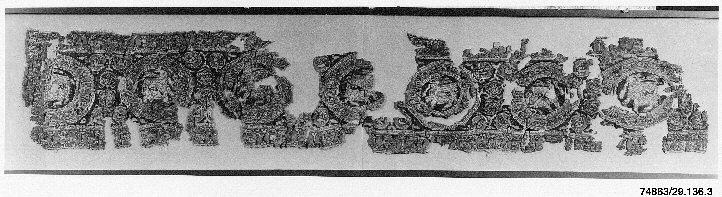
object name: band fragment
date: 901-1000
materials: silk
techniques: weave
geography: egypt